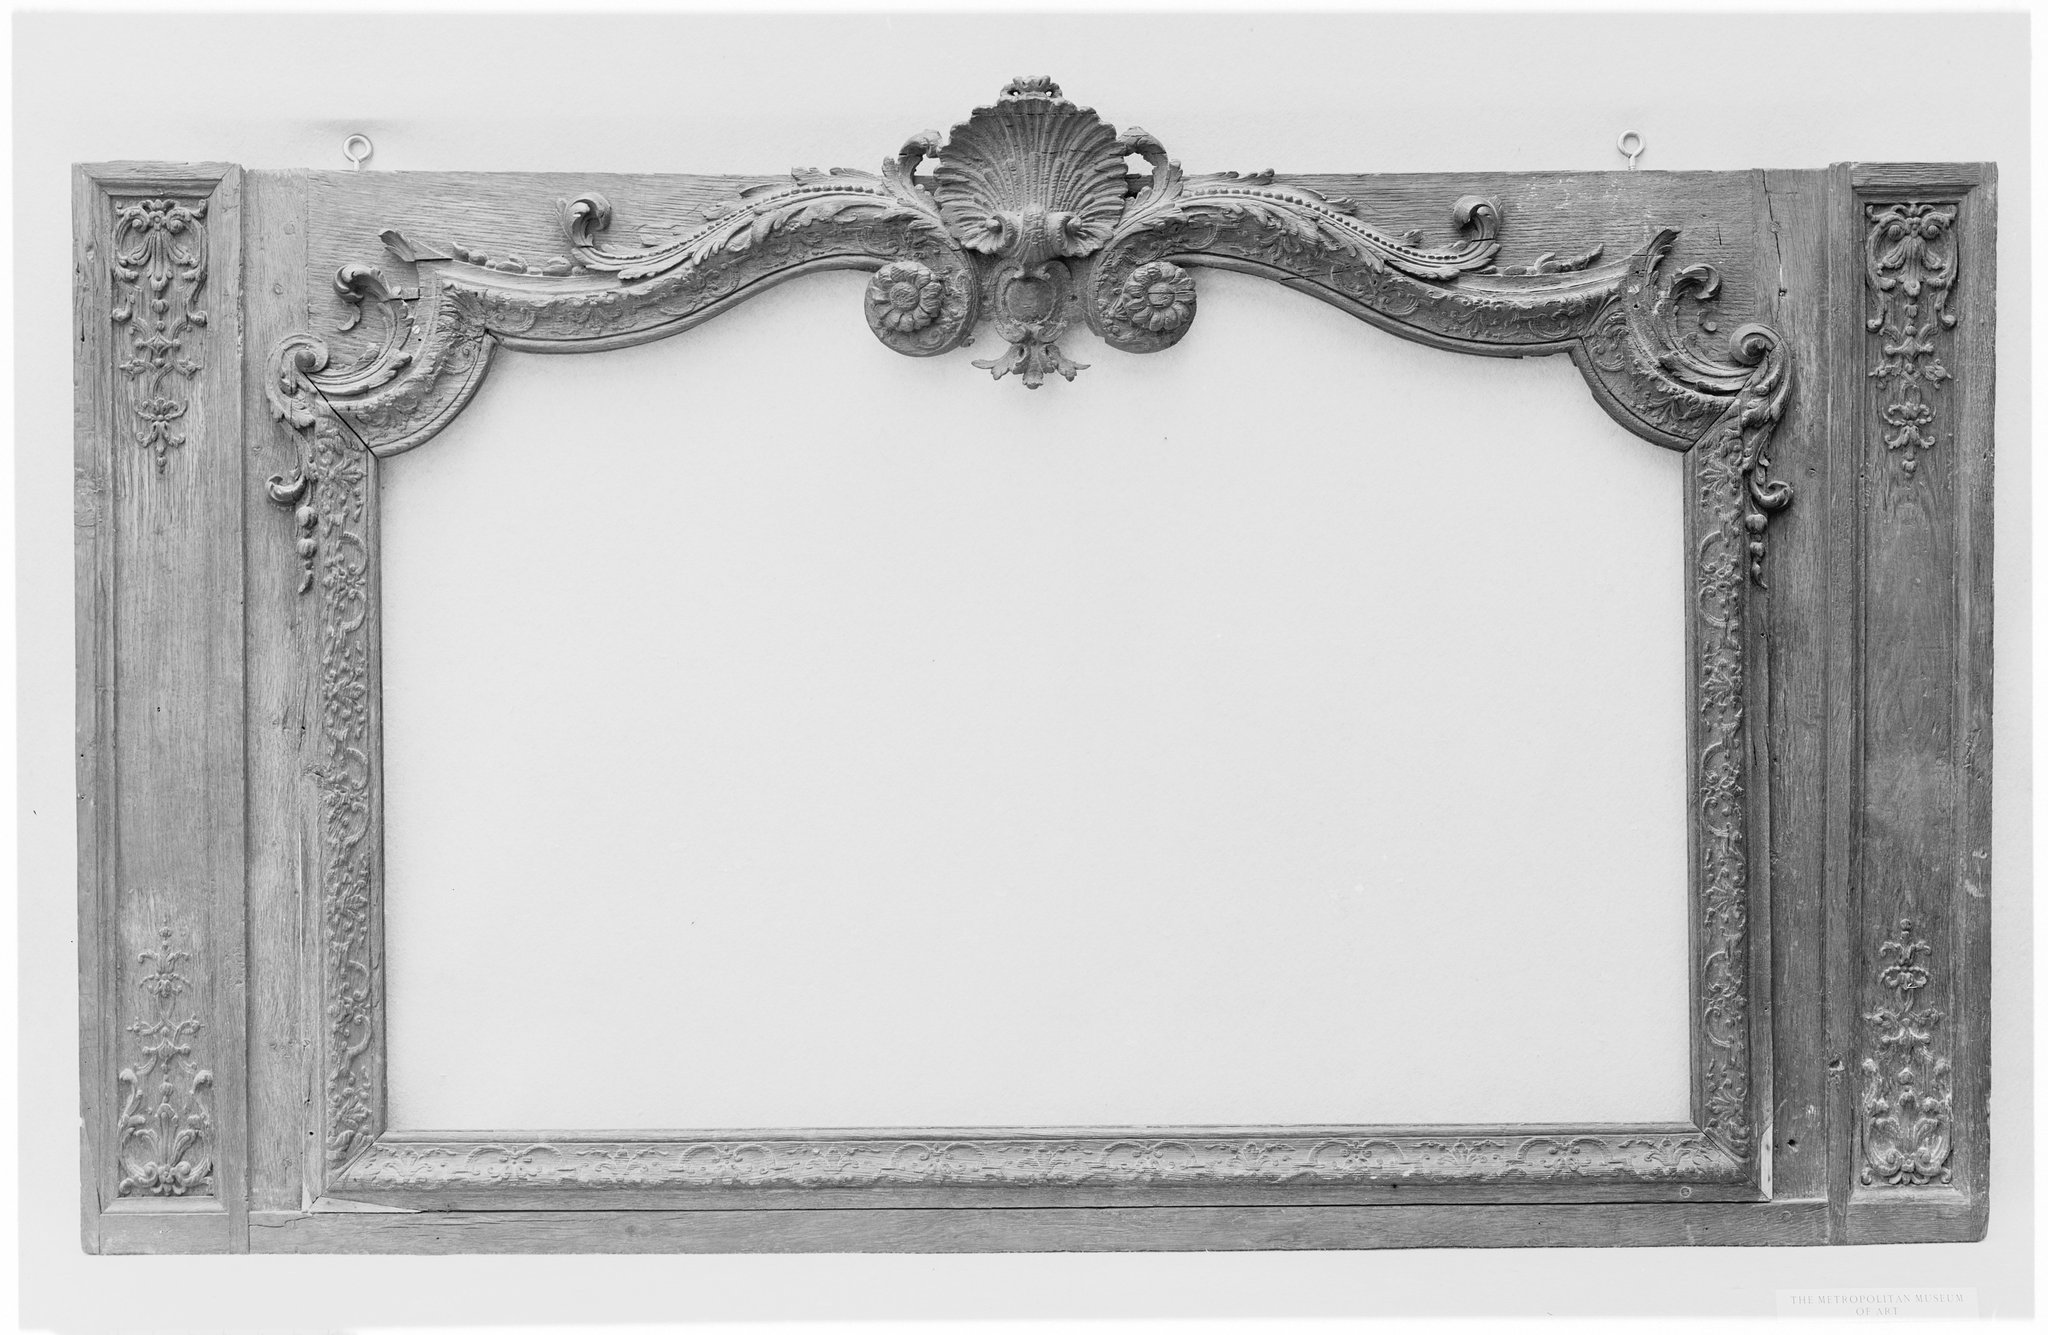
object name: overdoor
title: Overdoor (dessus de porte)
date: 1667-1700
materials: wood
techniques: carving